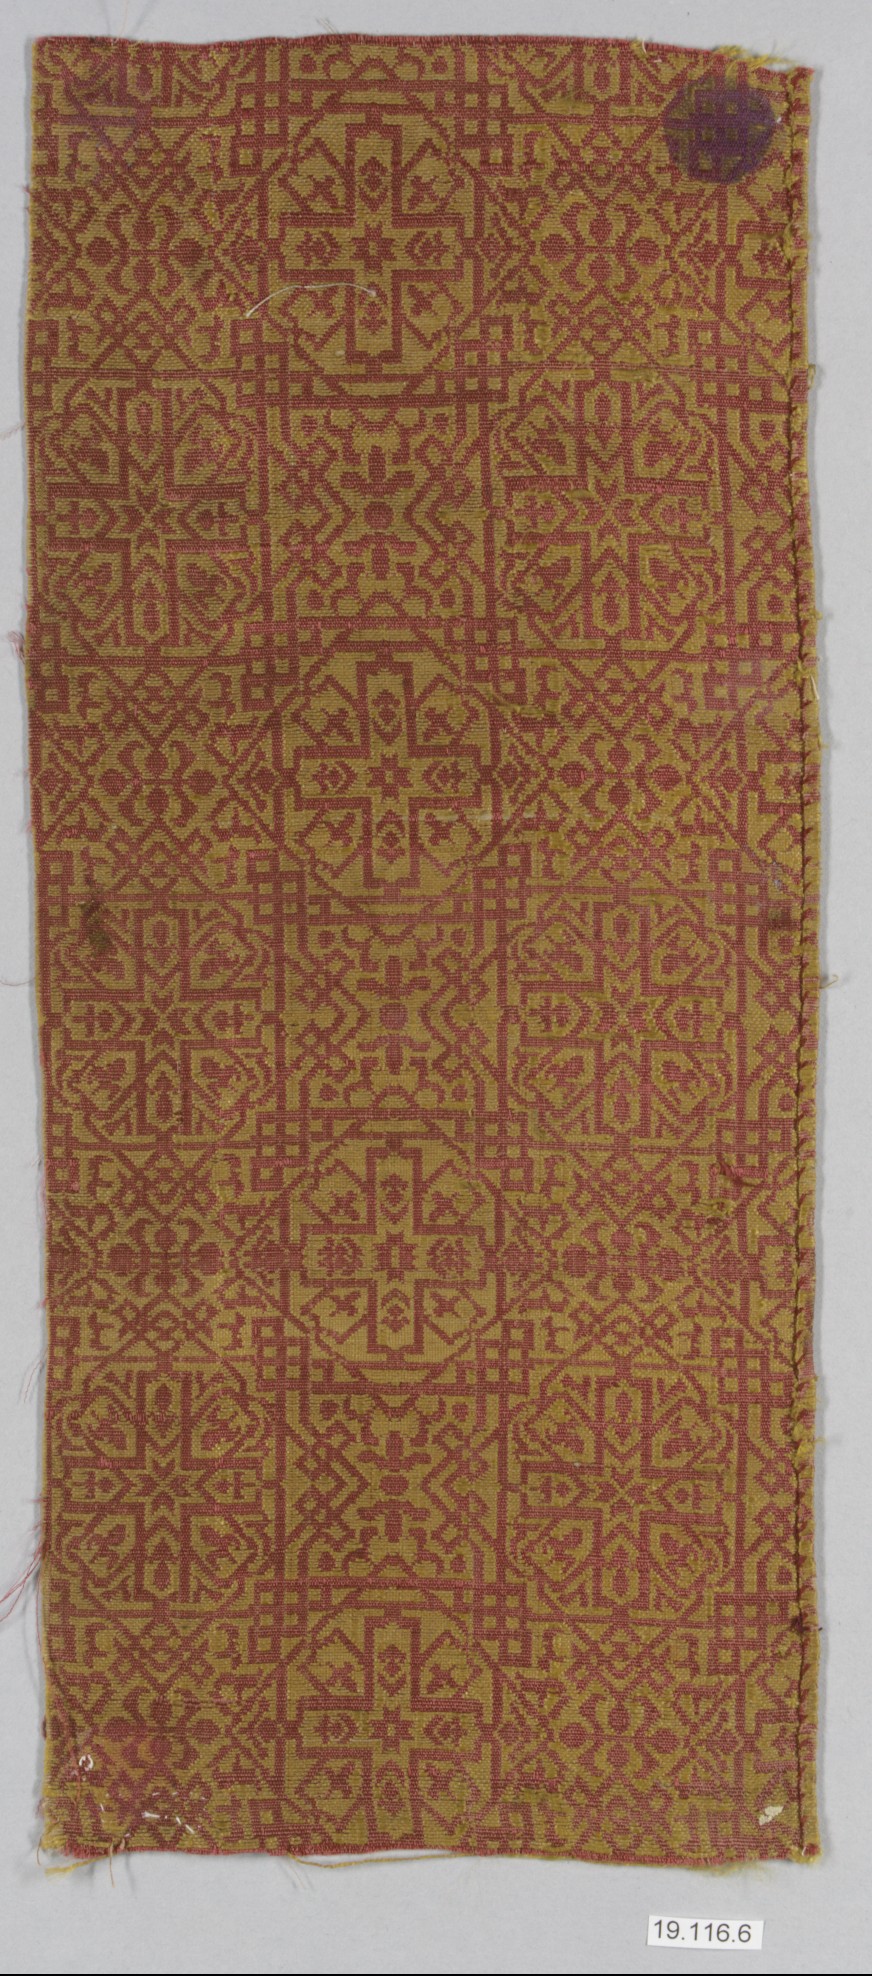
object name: textile fragment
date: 1401-1500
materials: silk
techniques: lampas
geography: spain